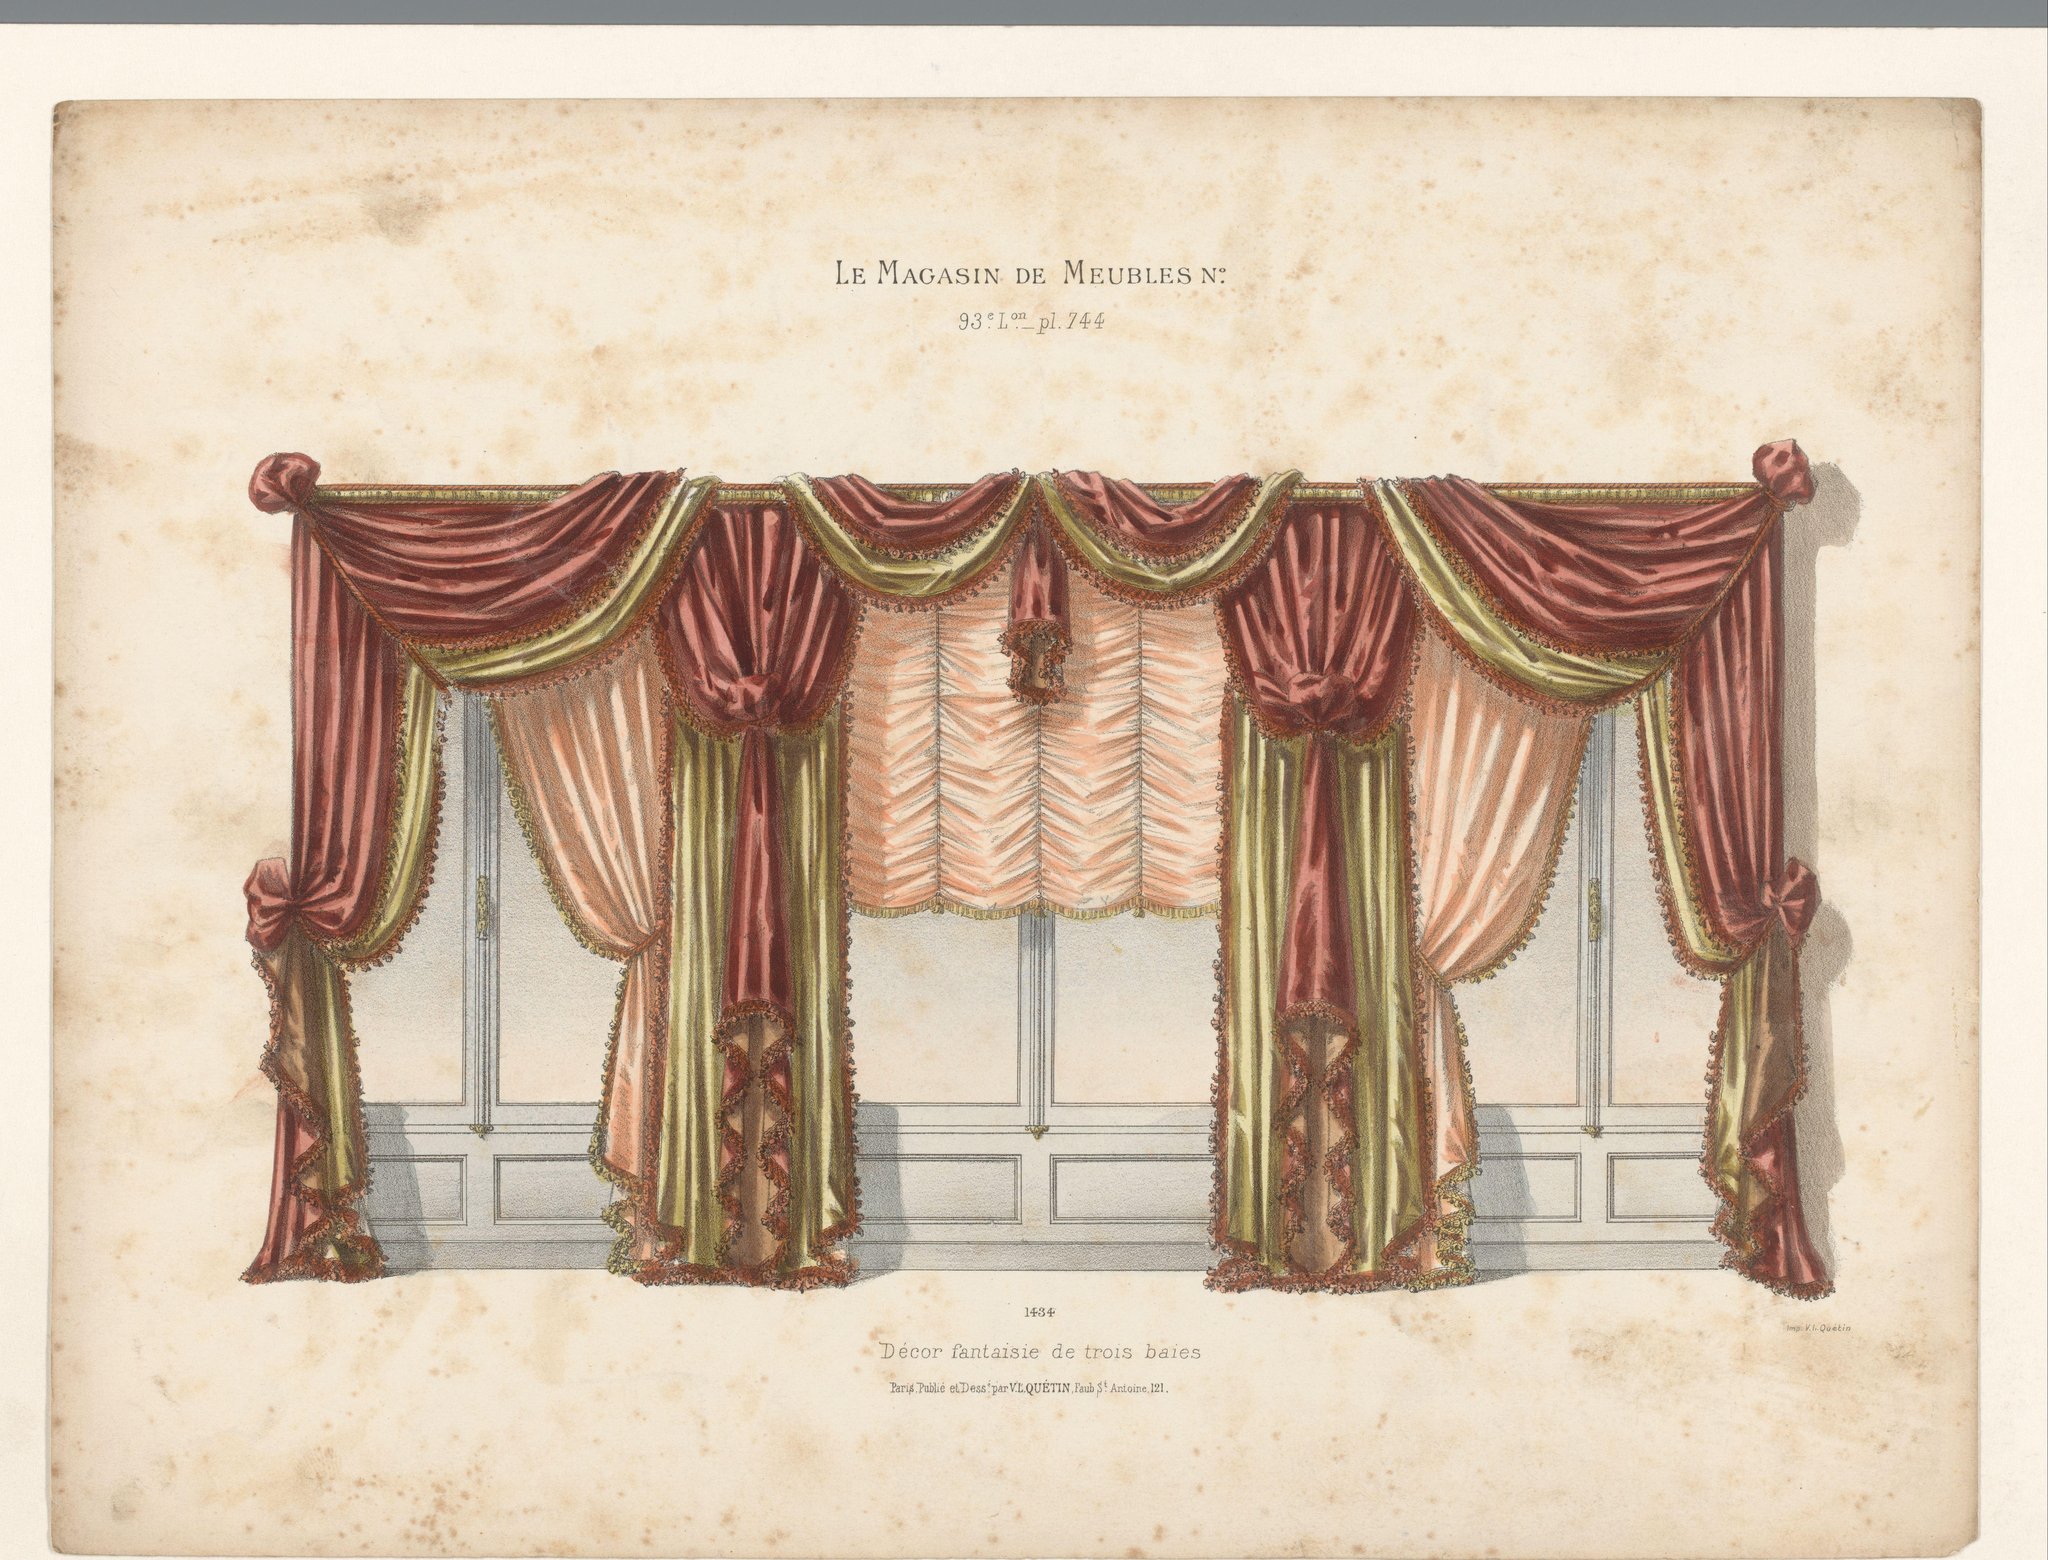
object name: print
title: Le Magasin de Meubles No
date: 1878-1904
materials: paper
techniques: hand coloring, lithograph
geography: paris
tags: window, hangings and drapery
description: Een raampartij van drie vensters met gedrapeerde gordijnen. Prent uit 93e Livraison.